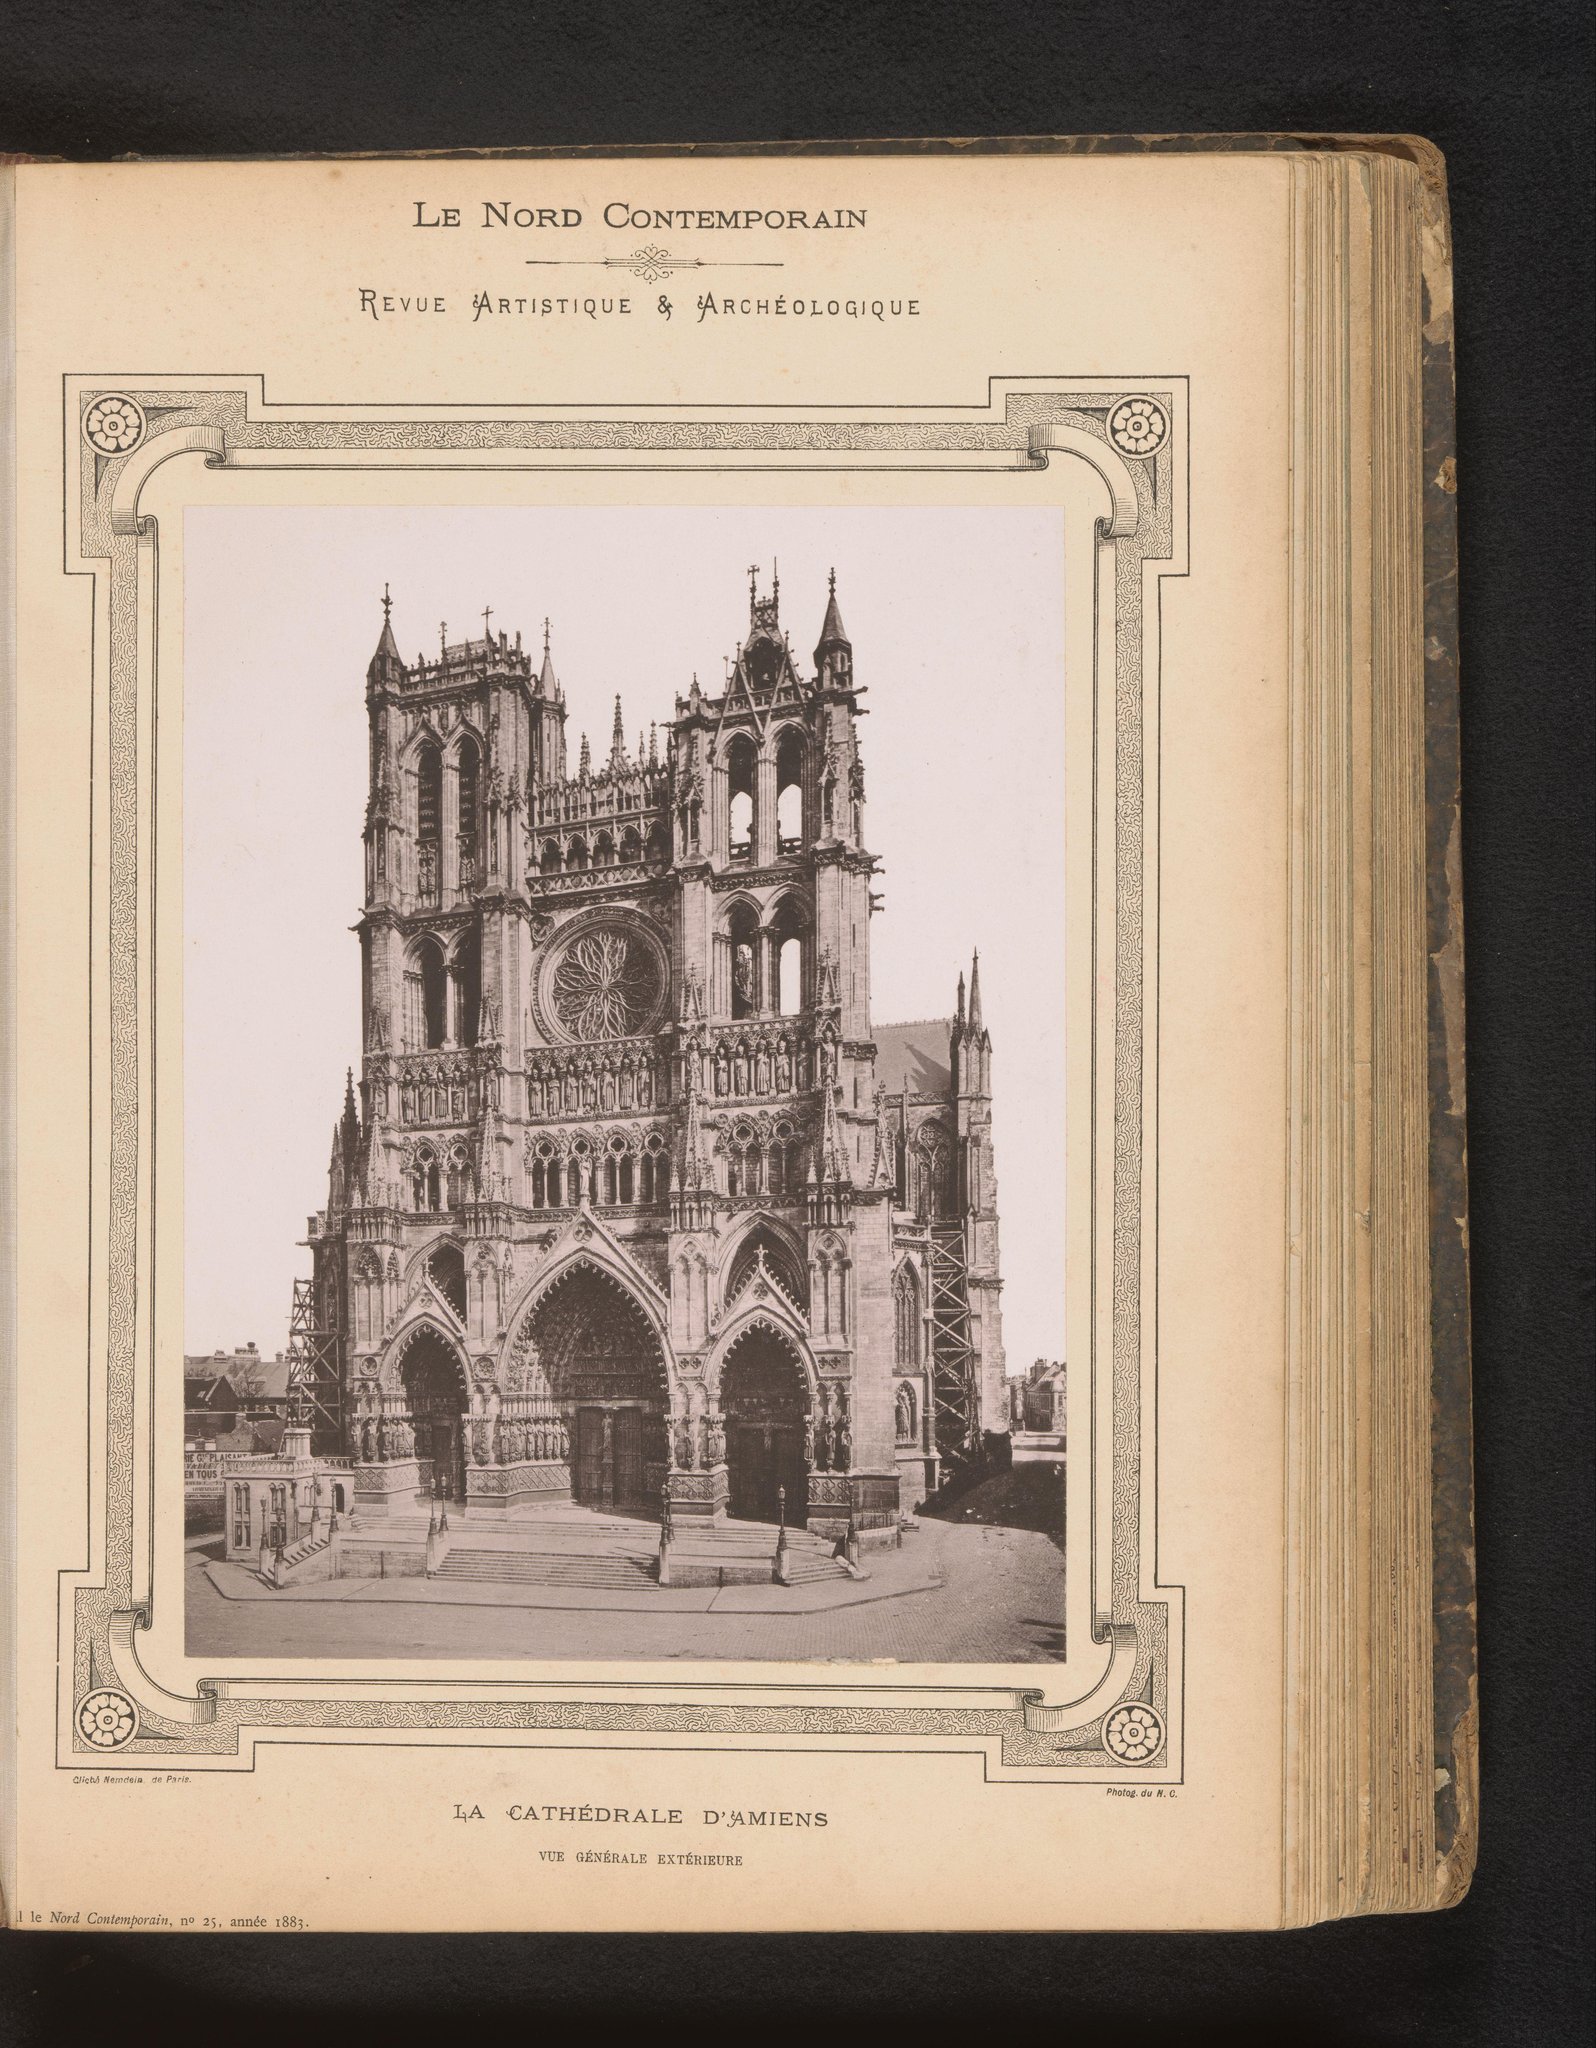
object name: page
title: Le Cathédrale d'Amiens, vue générale extérieure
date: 1878-1883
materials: paper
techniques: photograph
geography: amiens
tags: church (exterior), notre-dame d'amiens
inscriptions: inscription: ‘[Journa]l le Nord Contemporain, No 25, année 1883.’, inscription: ‘Le Nord Contemporain/ Revue Artistique & Archéologique’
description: Prent op derde ongenummerde pagina na pagina 16.